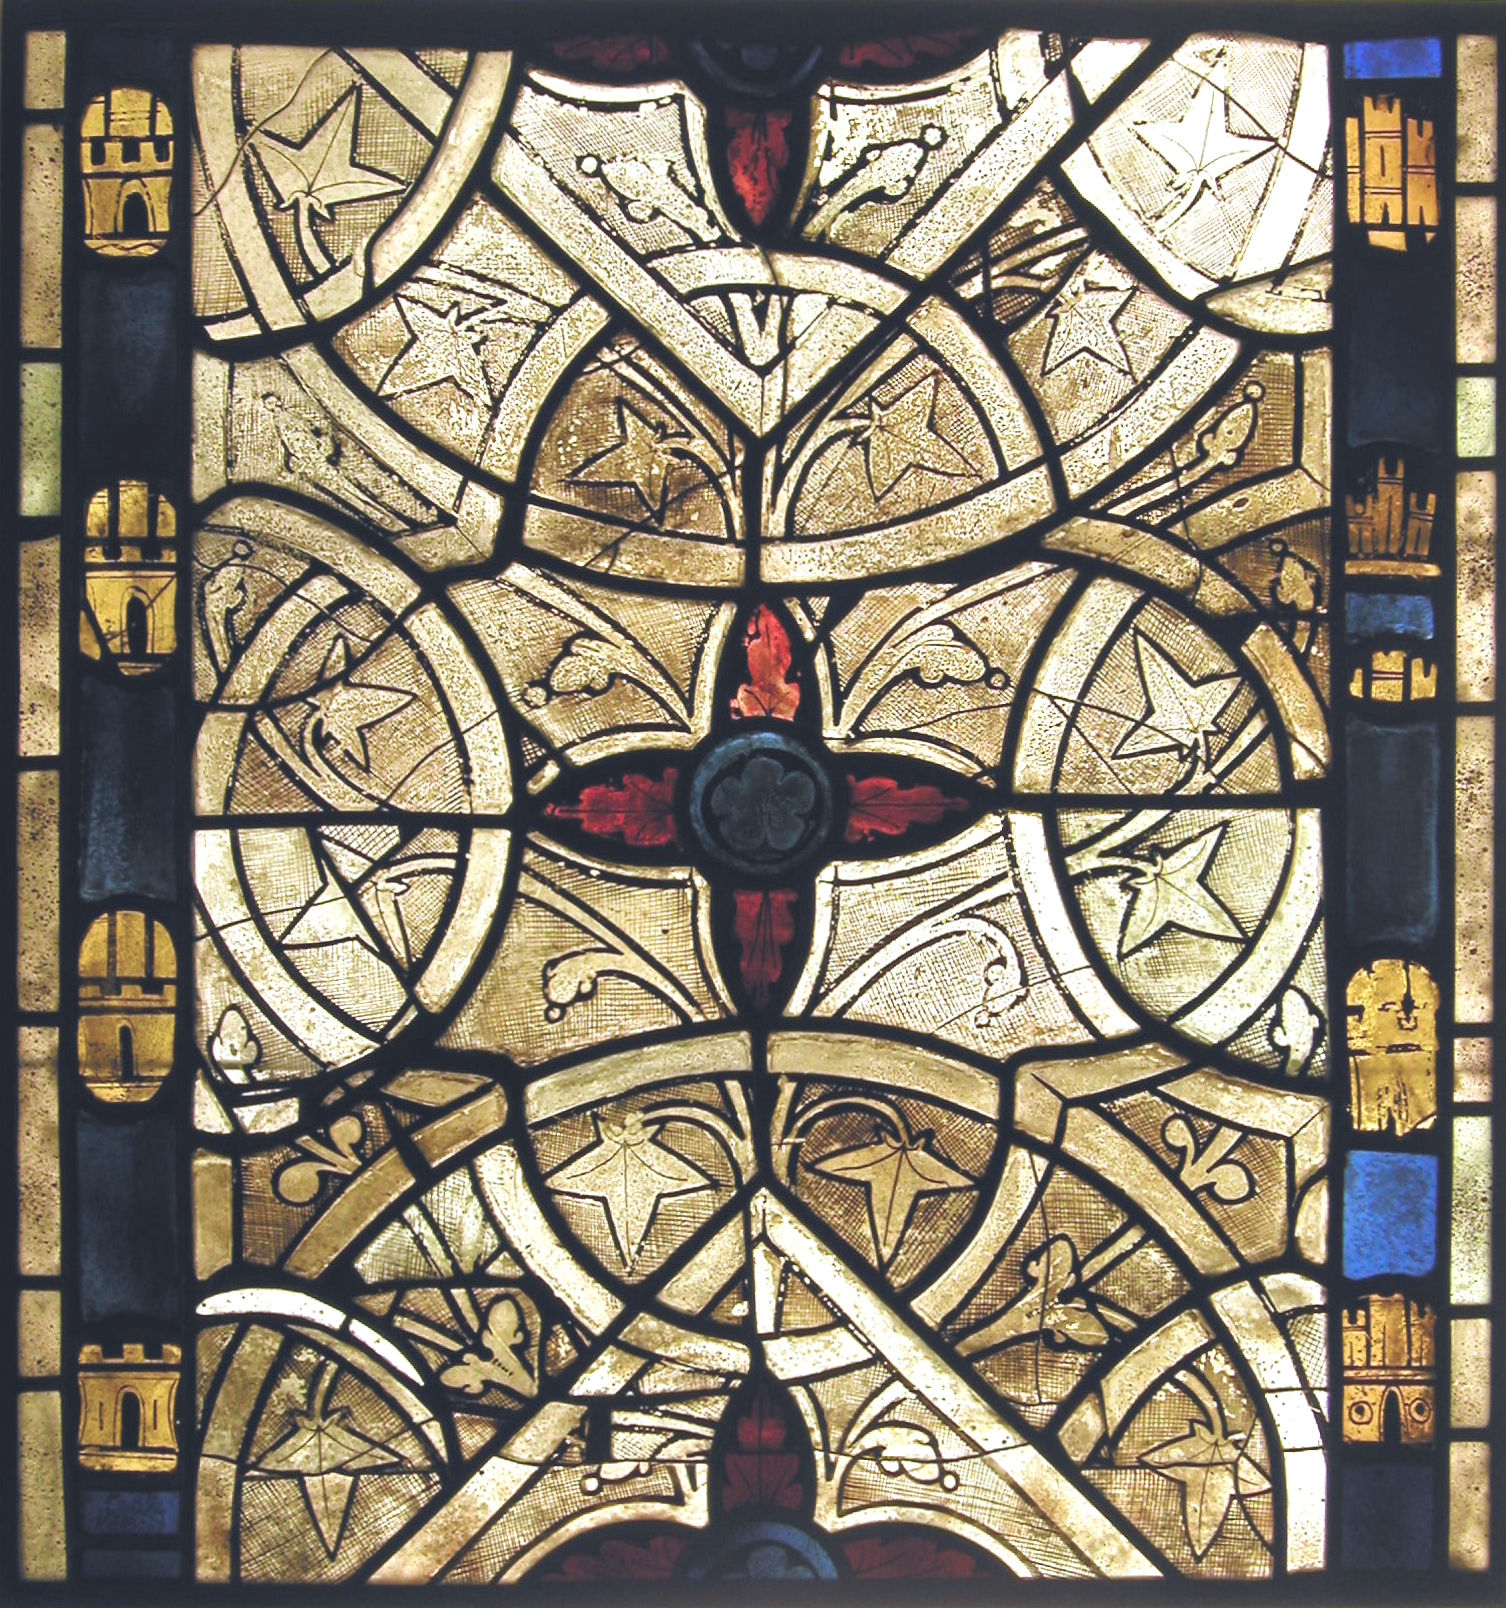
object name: panel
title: Grisaille Panel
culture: french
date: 1265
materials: glass, metal, paint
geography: france